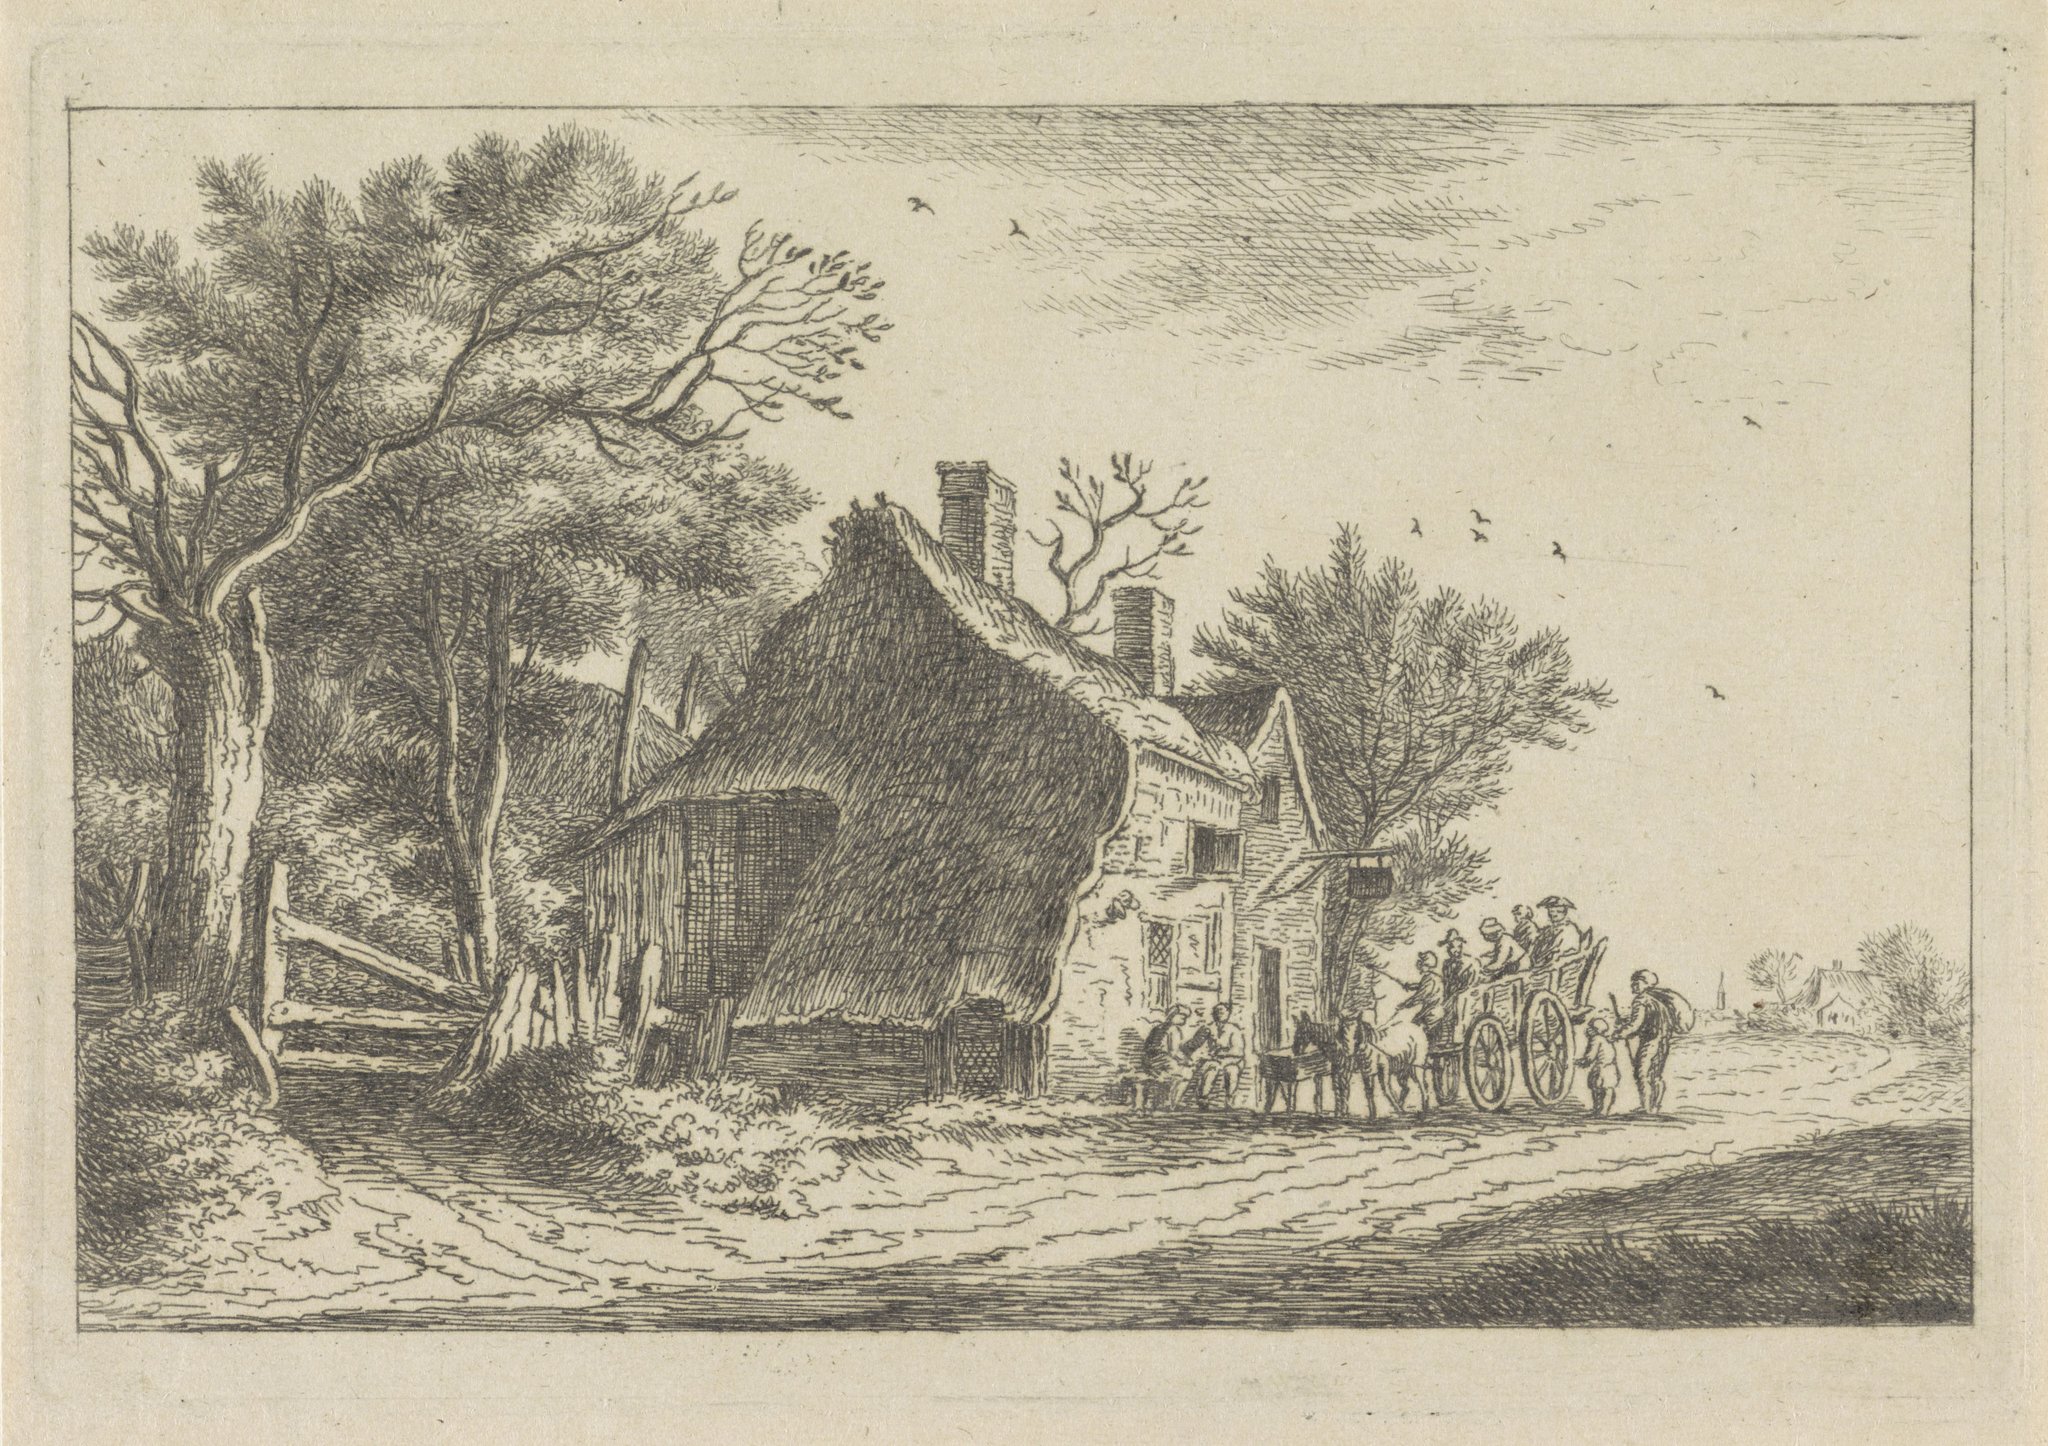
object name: print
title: Landschappen met bebouwing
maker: Anonymous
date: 1630-1740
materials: paper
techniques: etching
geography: amsterdam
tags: city-view, and landscape with man-made constructions, (farm) wagon, freight wagon, cart (+ zoological aspects of animals in traffic and transport), inn, coffee-house, public house, etc., 'en route', traveller under way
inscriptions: collector's mark: Lugt 2228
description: Voor een herberg staan reizigers bij een paard-en-wagen. Er zitten vijf mensen in de wagen en er komen nog twee reizigers aangelopen.